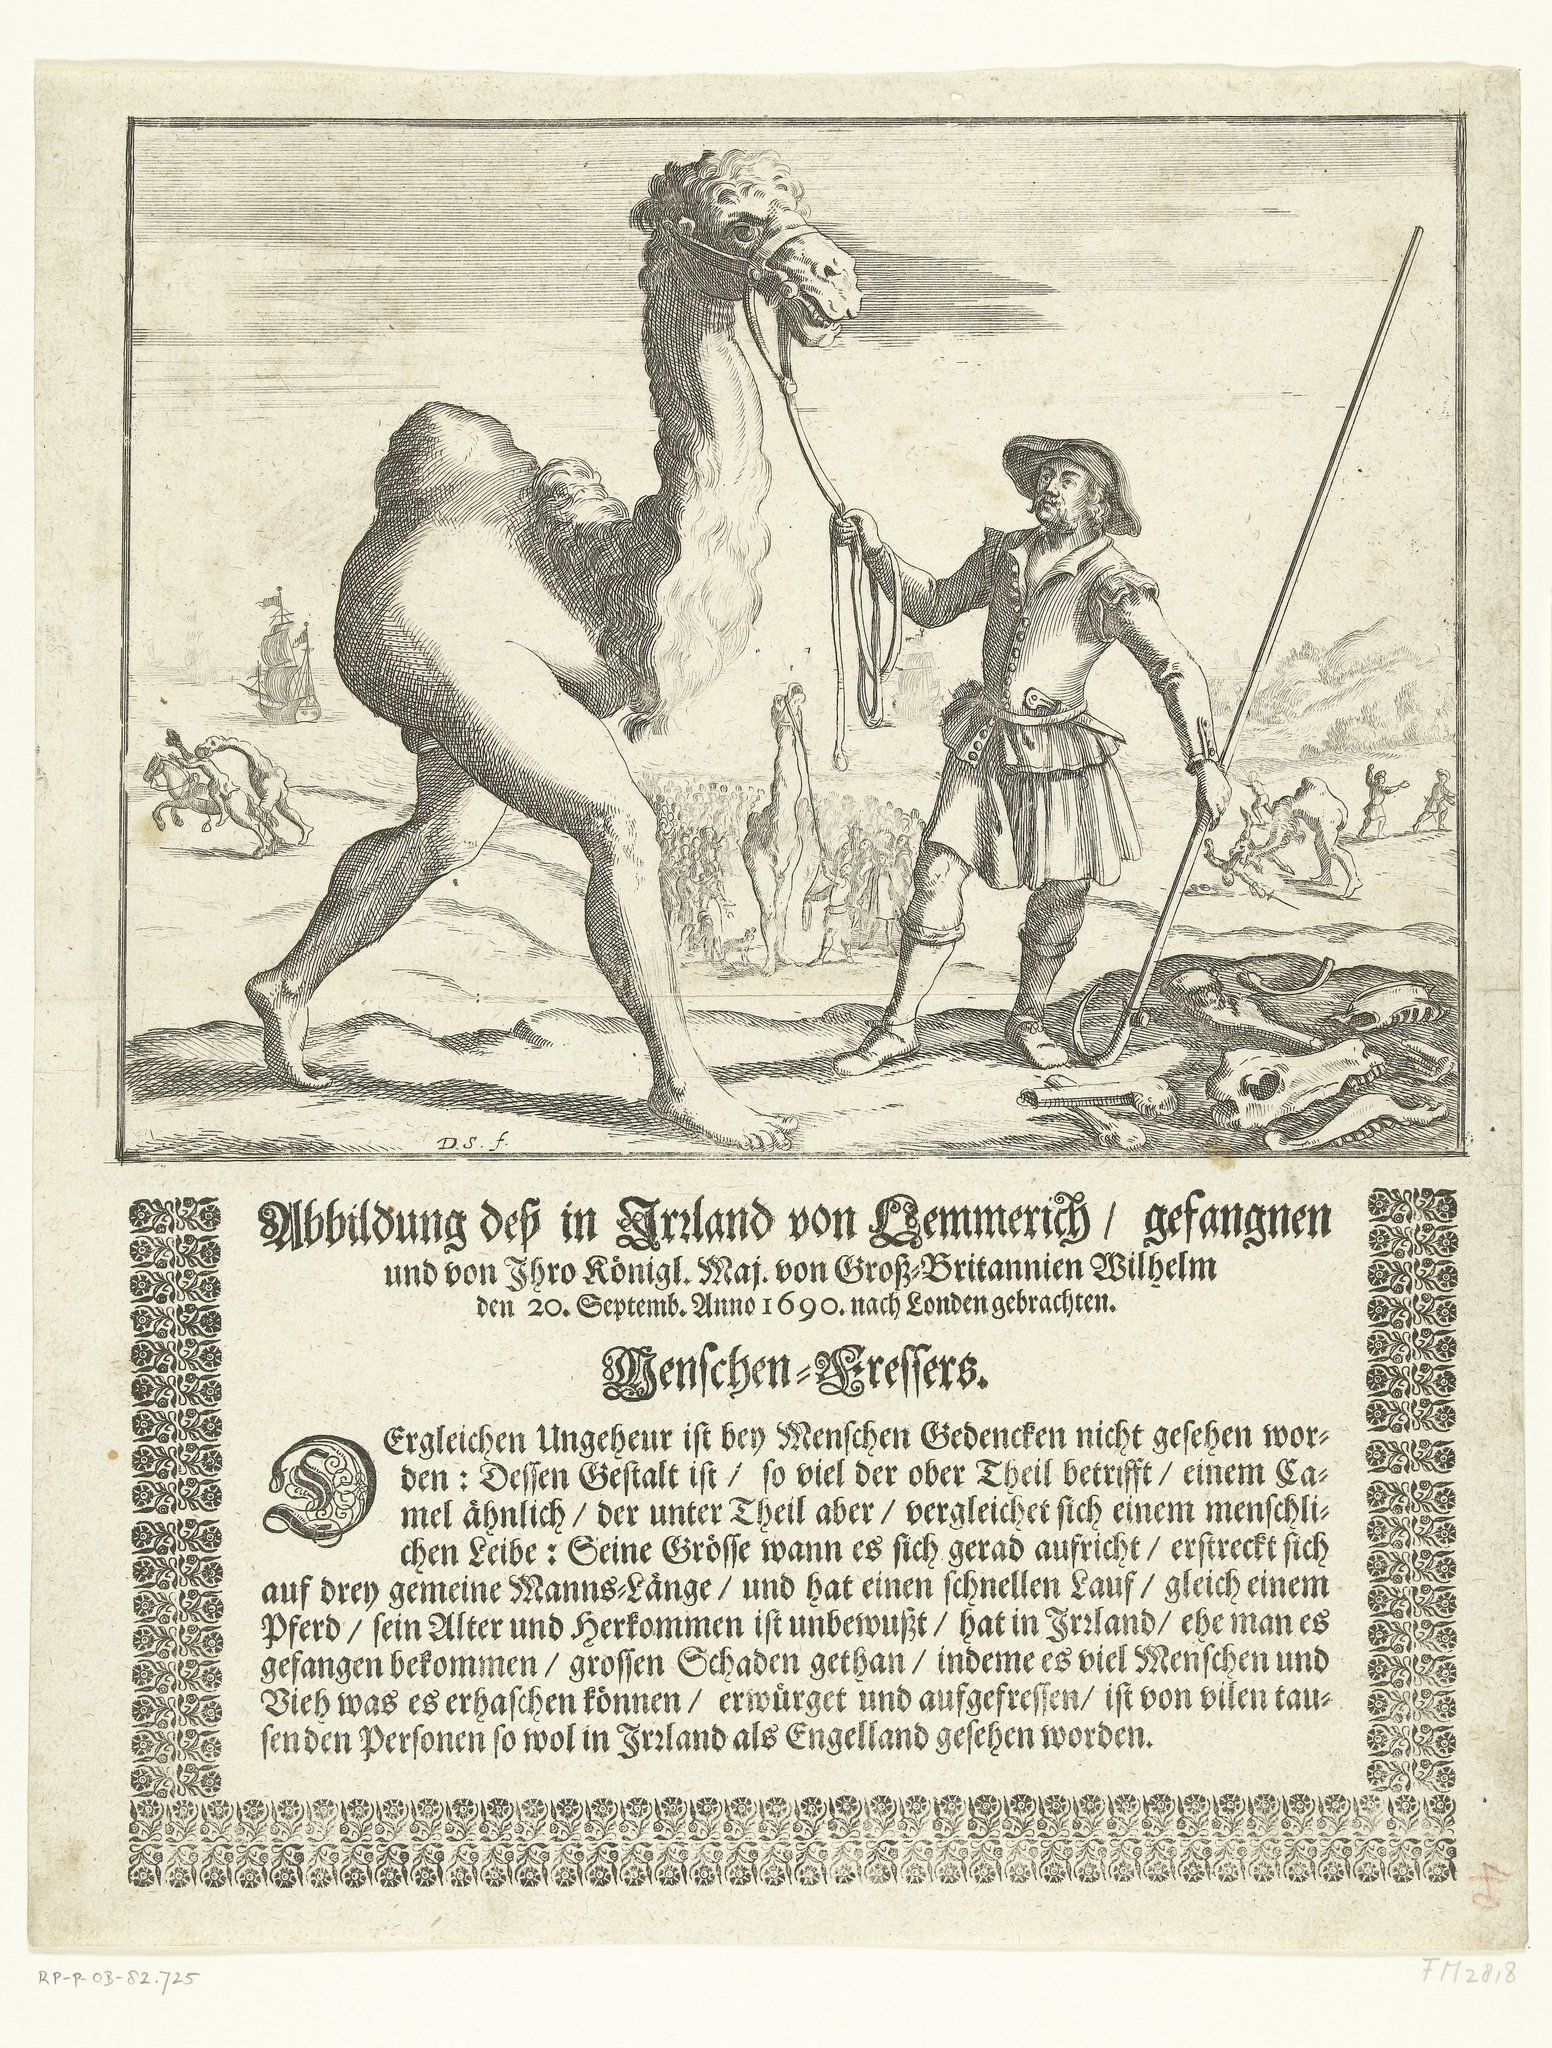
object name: print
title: Abbildung deß in Irrland vom Lemmerich / gefangnen und von Ihro Königl. Maj. von Groß-Britannien Wilhelm den 20. Septemb. Anno 1690. nach Londen gebrachten Menschen-Fressers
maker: Anonymous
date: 1664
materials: paper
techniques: engraving, etching, letterpress printing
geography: germany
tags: monsters ~ hoofed animals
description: Mensenetend monsterlijk dier dat half mens en half kameel is. Volgens de tekst is het beest gevangengenomen door de troepen van koning Willem III bij Limerick op 20 september 1690 en naar Londen overgebracht.